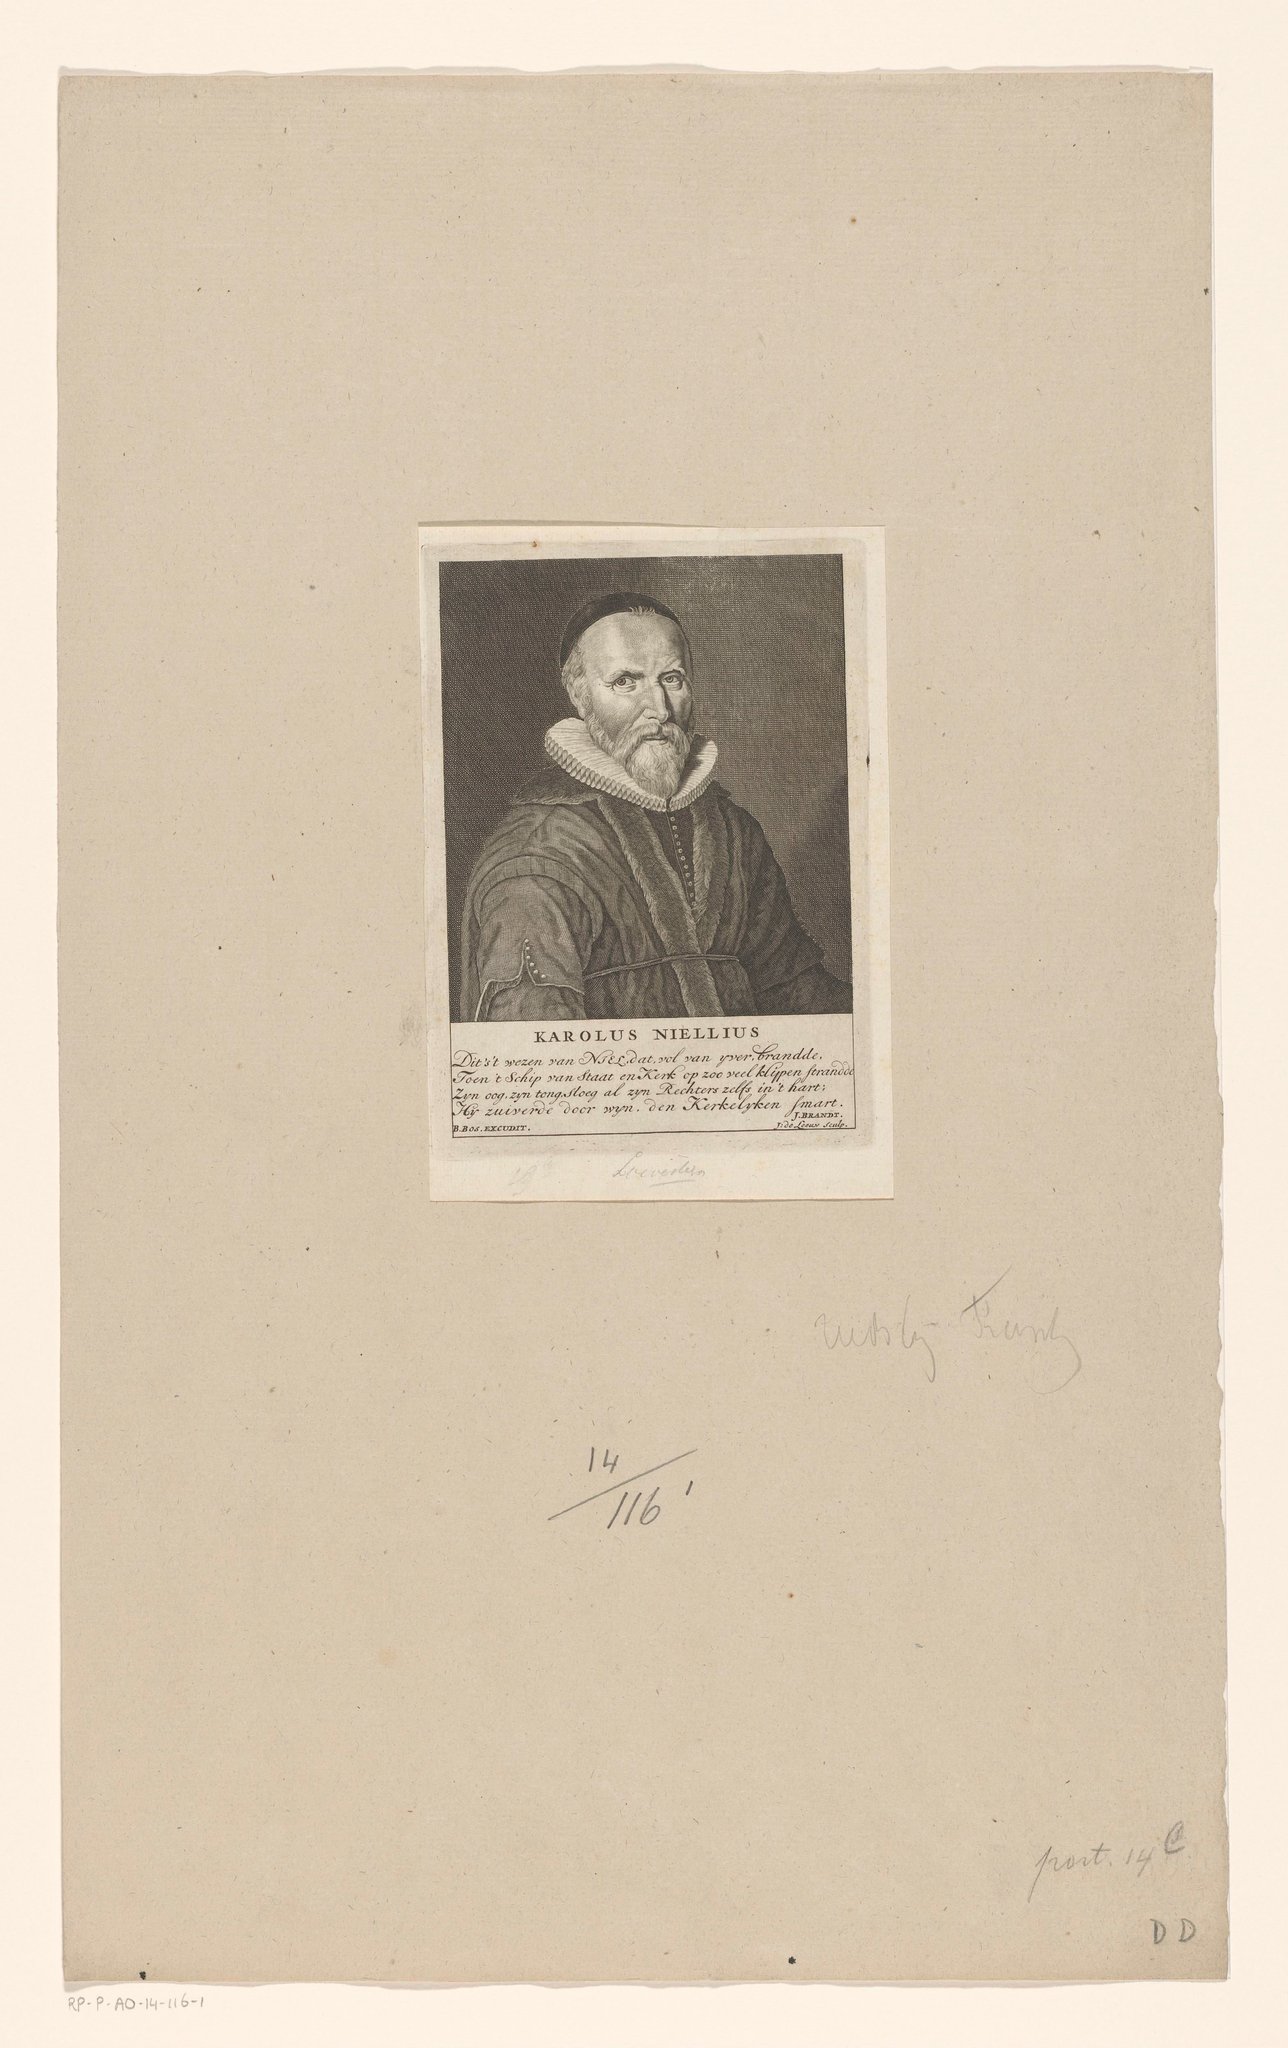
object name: print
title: Portret van Carolus Niellius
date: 1704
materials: paper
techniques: engraving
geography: the hague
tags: historical persons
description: Portret van Carolus Niellius, Utrechts predikant en remonstrants predikant te Amsterdam, met kalot. Onder het portret staat de naam van de geportretteerde, gevolgd door een vierregelig Nederlands vers.